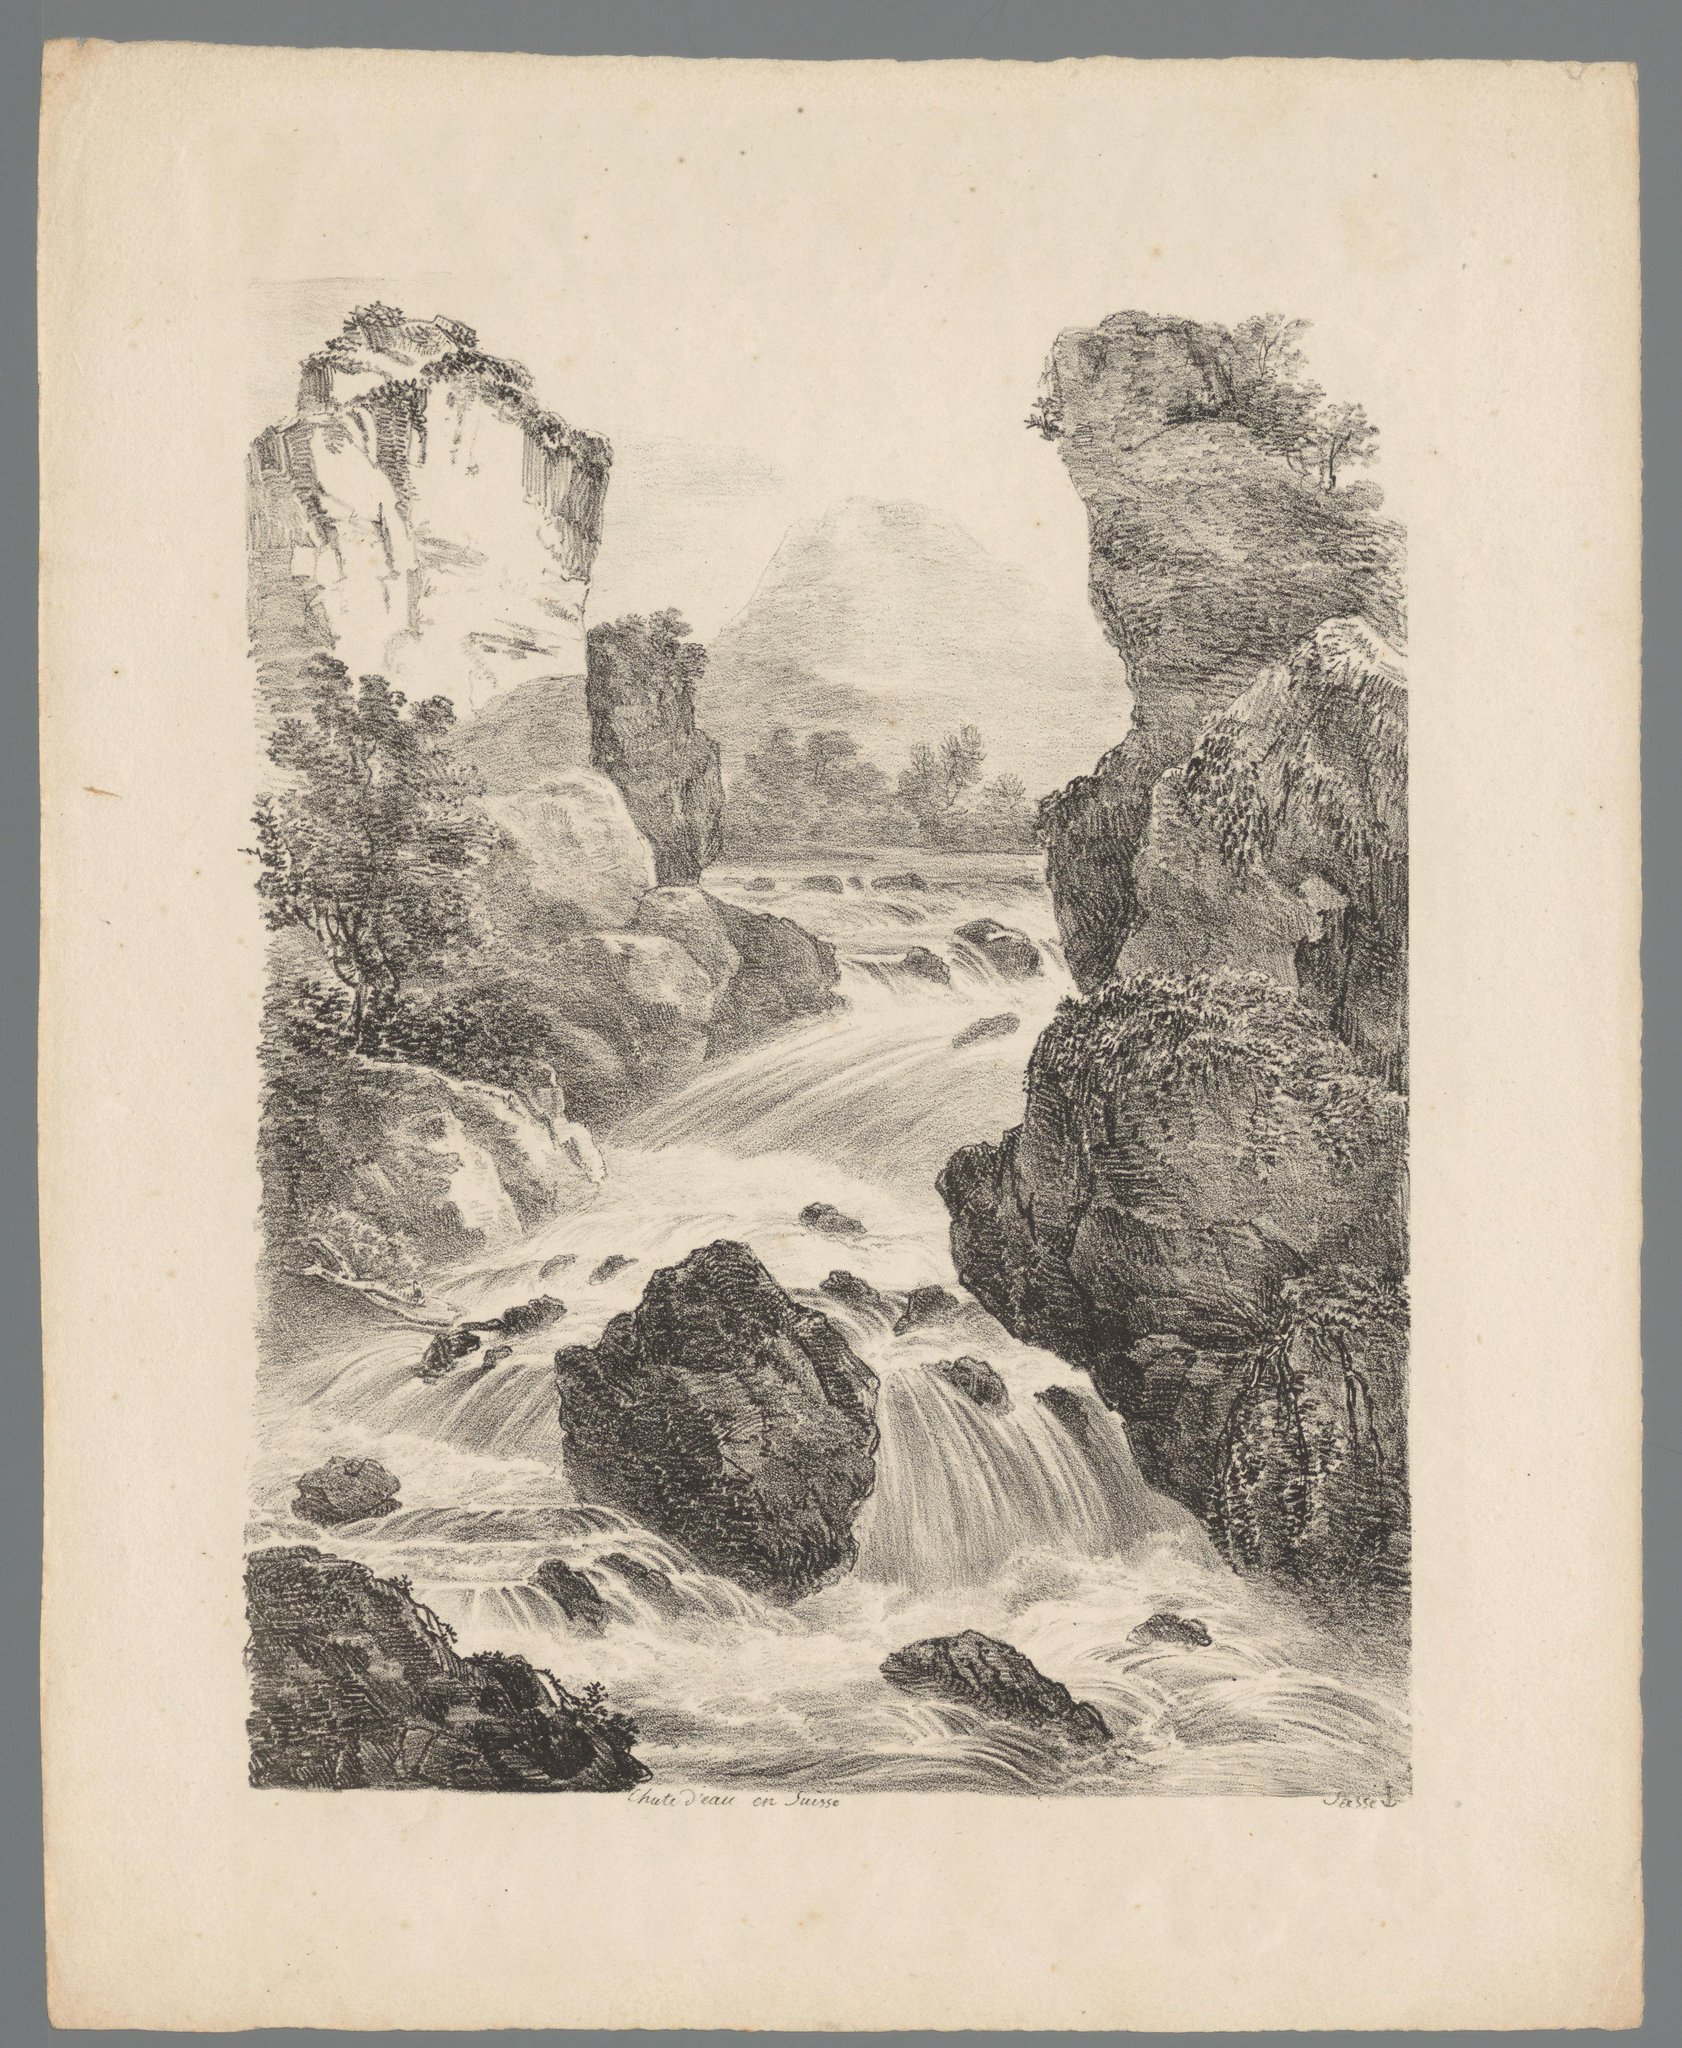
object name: print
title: L'art de dessiner le paysage d'apres nature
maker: richard sasse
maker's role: print maker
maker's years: 1774-1849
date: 1800-1849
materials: paper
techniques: lithograph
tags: waterfall, switzerland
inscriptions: collector's mark: Lugt 2228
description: Prent behoort tot de serie 'L'art de dessiner le paysage d'apres nature'. Deze serie is in tien delen met elk zes lithografieën uitgegeven.